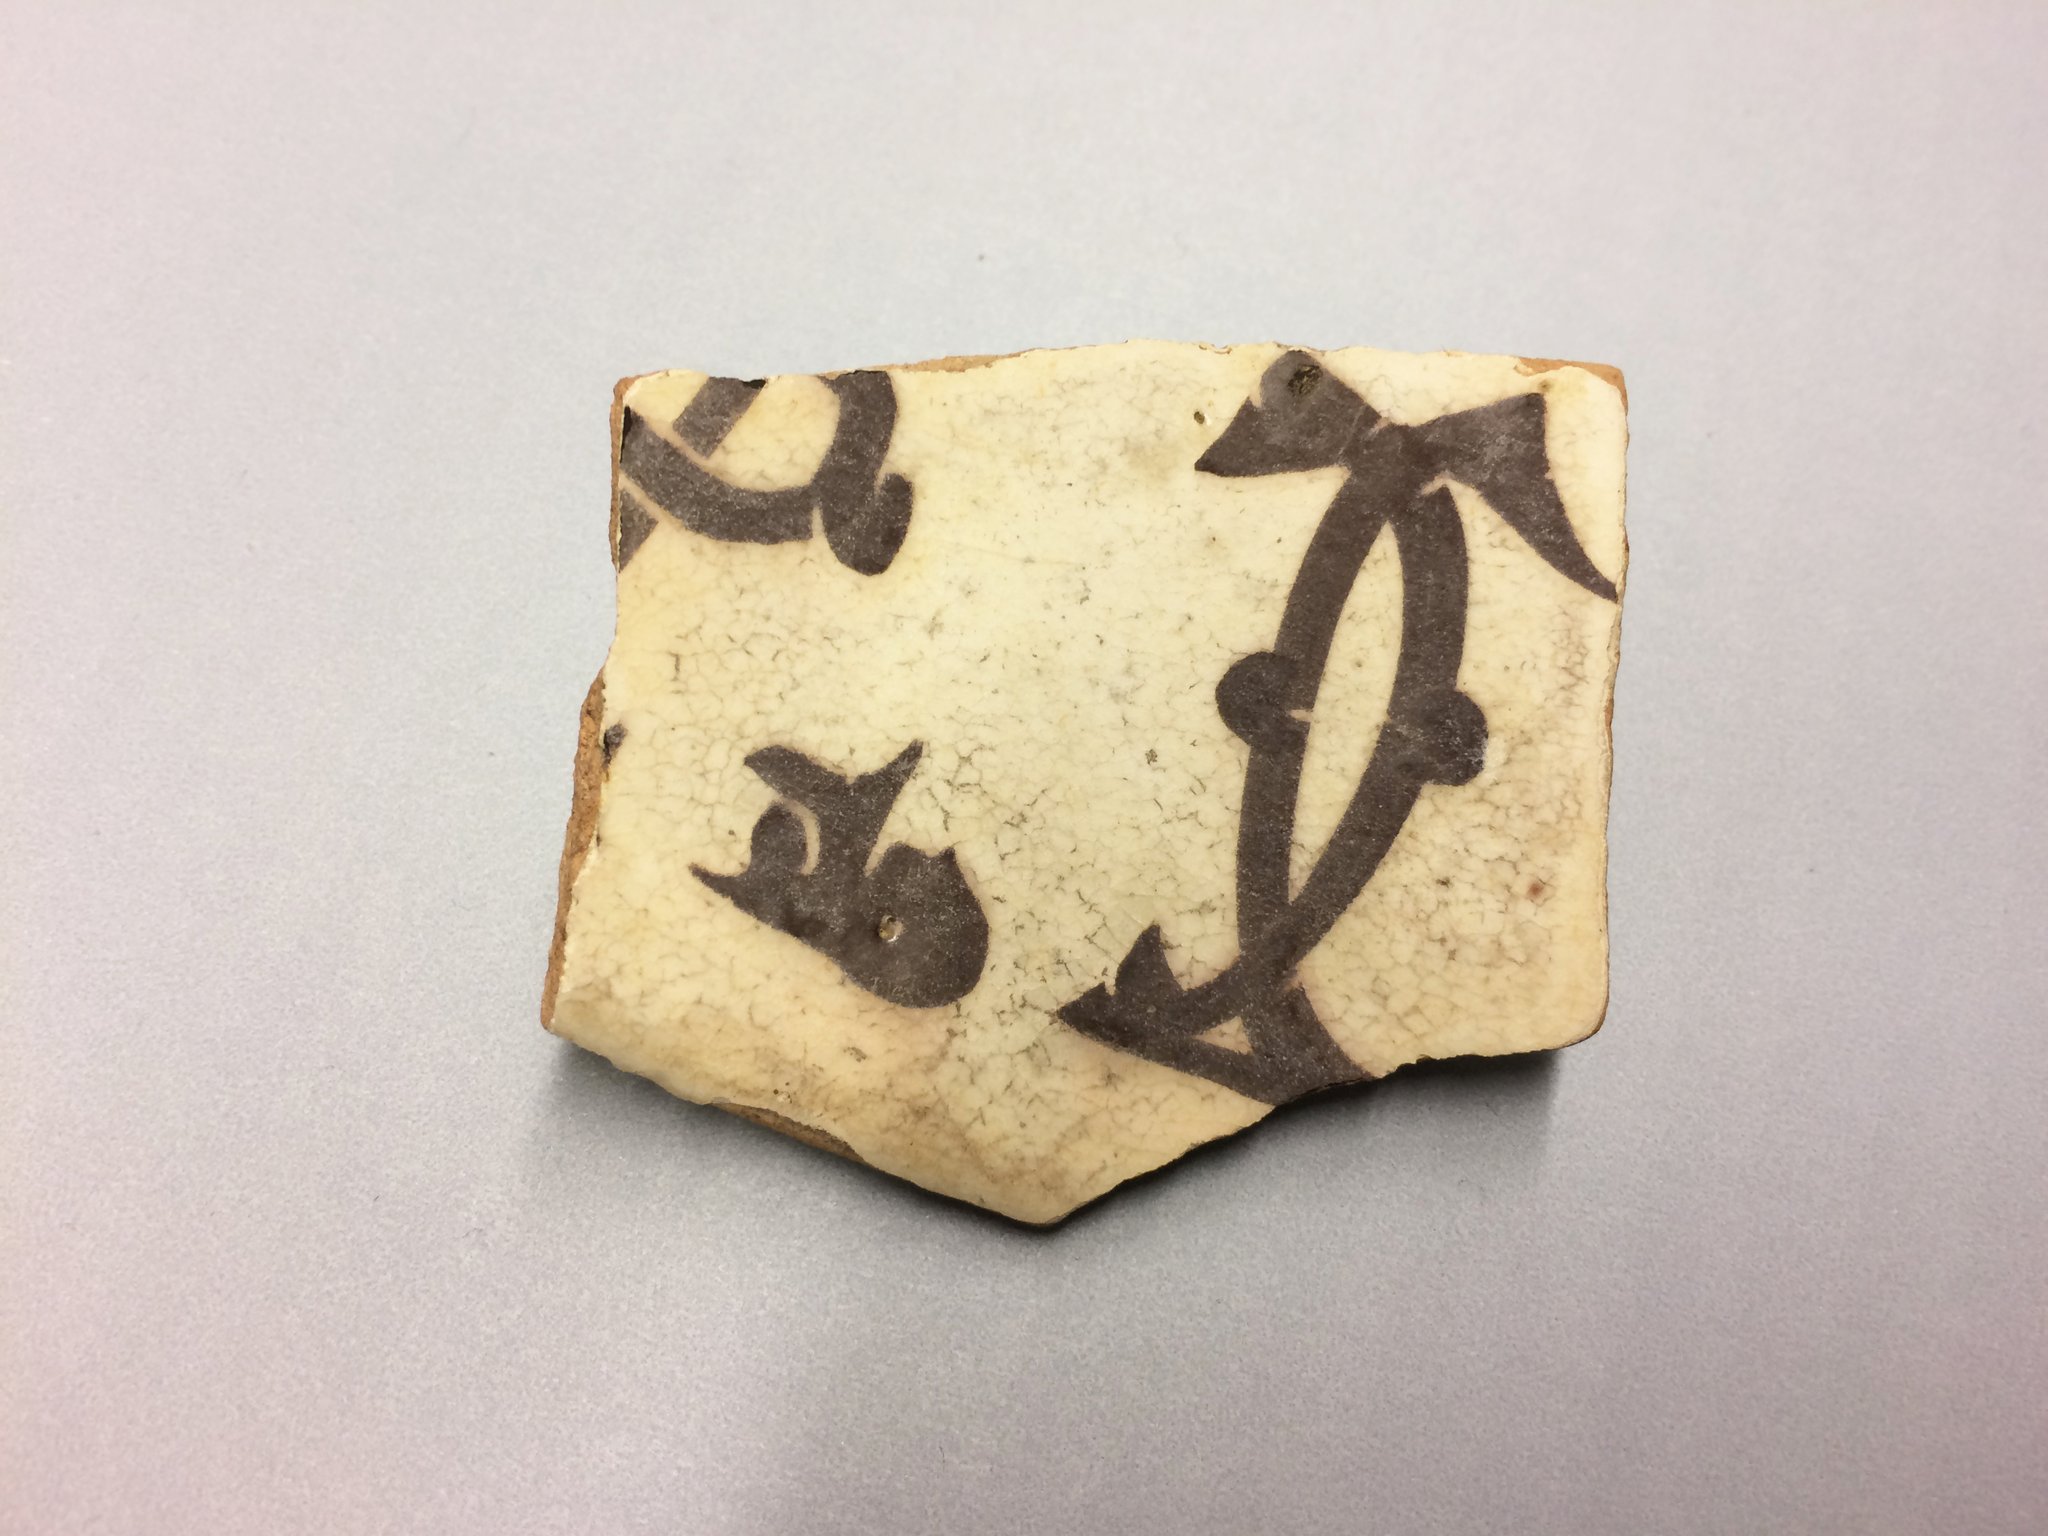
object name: fragment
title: Ceramic Fragment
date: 1001-1200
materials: earthenware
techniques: glazing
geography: iran